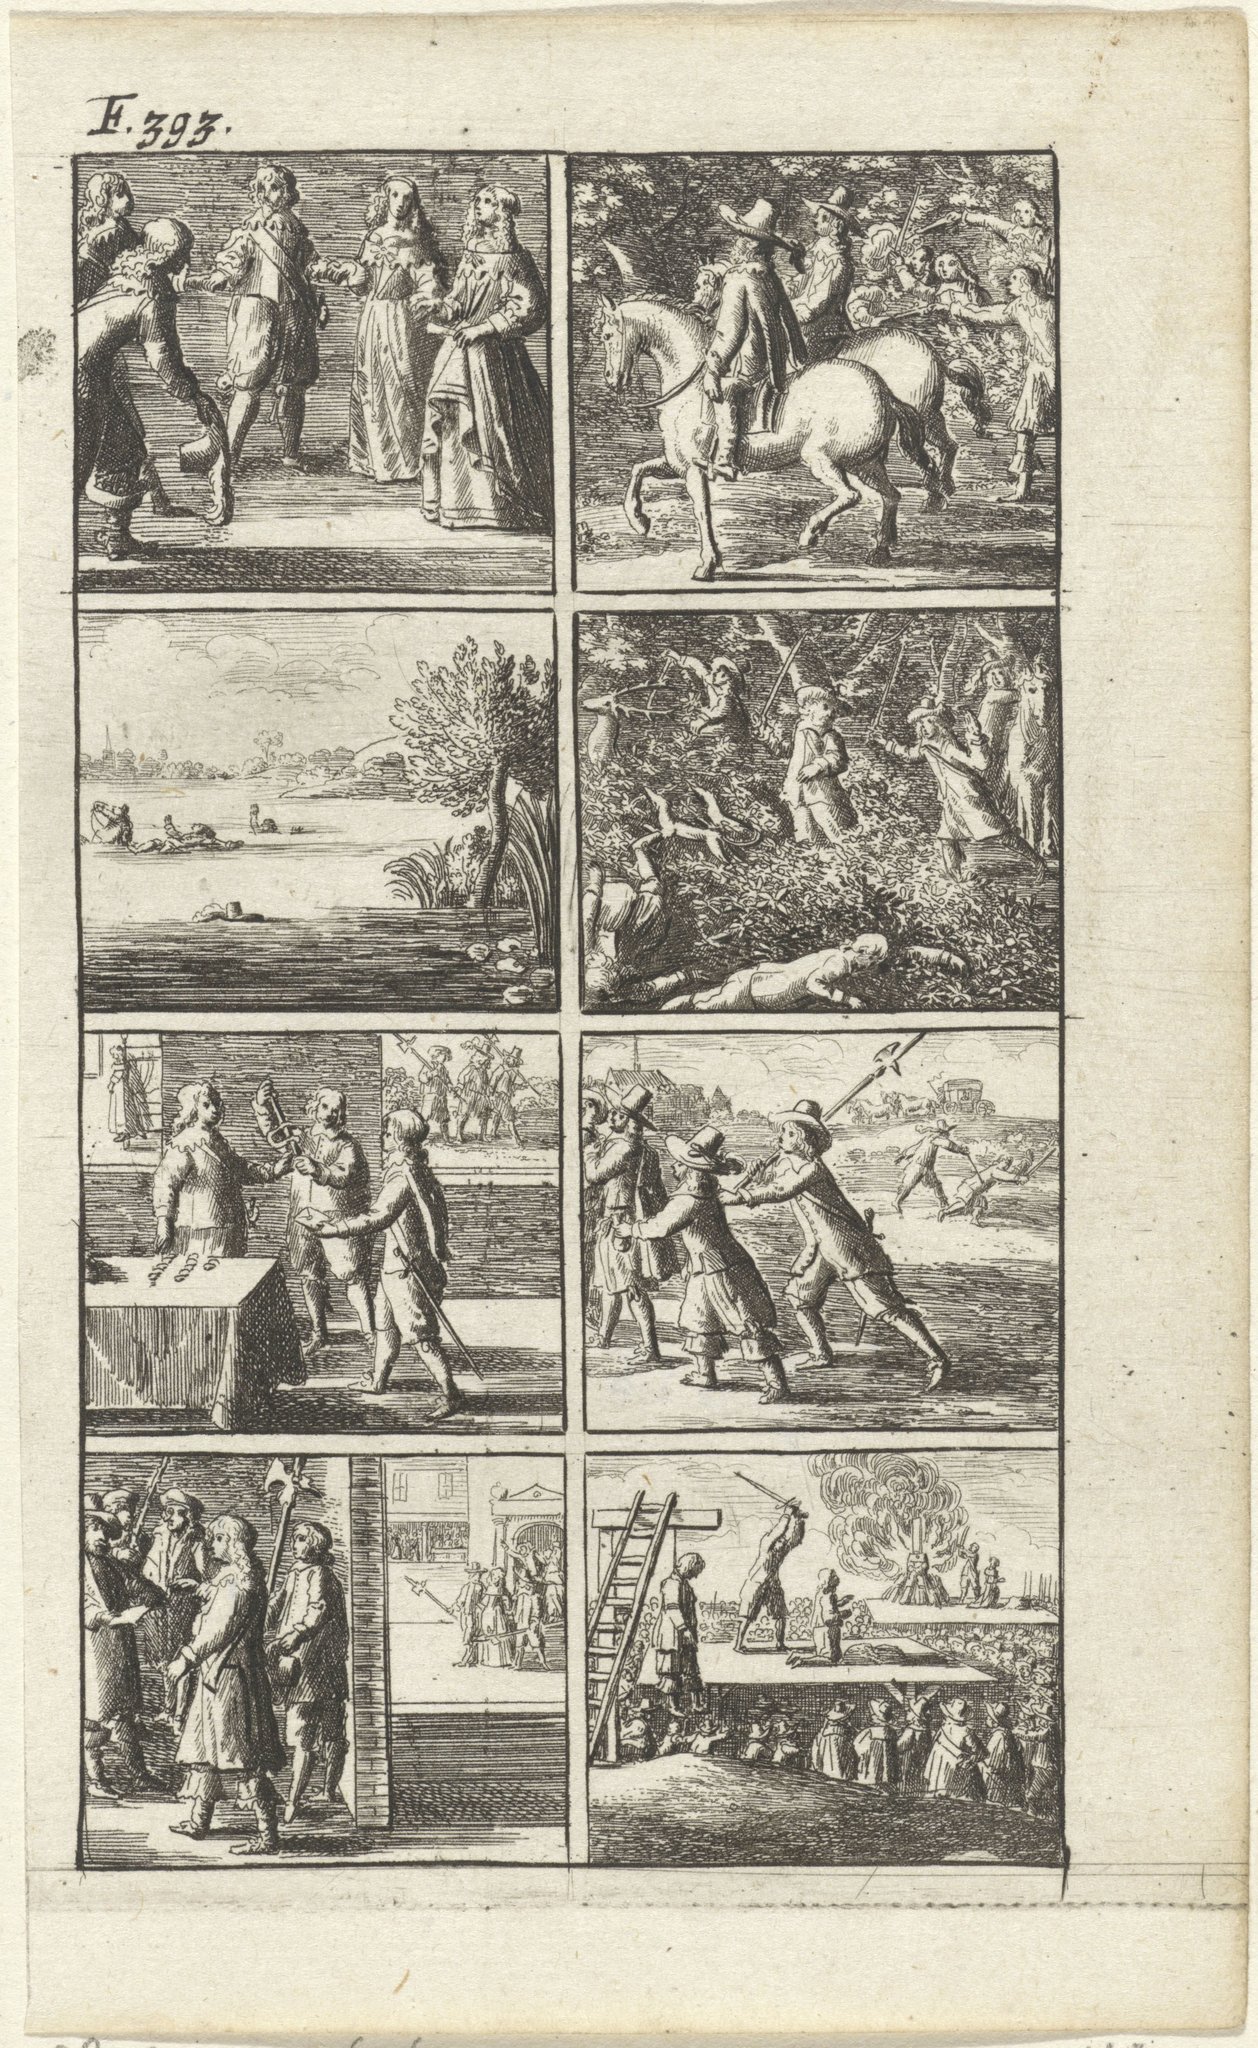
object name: book illustration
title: Verhaal met voorstellingen van moord en doodstraf (F. 393.)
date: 1667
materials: paper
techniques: etching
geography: netherlands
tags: death penalty, execution, murder, fighting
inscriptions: collector's mark: Lugt 2166, collector's mark: Lugt 2760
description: Verhaal in acht scènes met enkele voorstellingen van moord en doodstraf. Onder andere van mannen die verdrinken een rivier, een gevecht in het bos, een onthoofding en van een persoon op een brandstapel. Linksboven: F. 393.